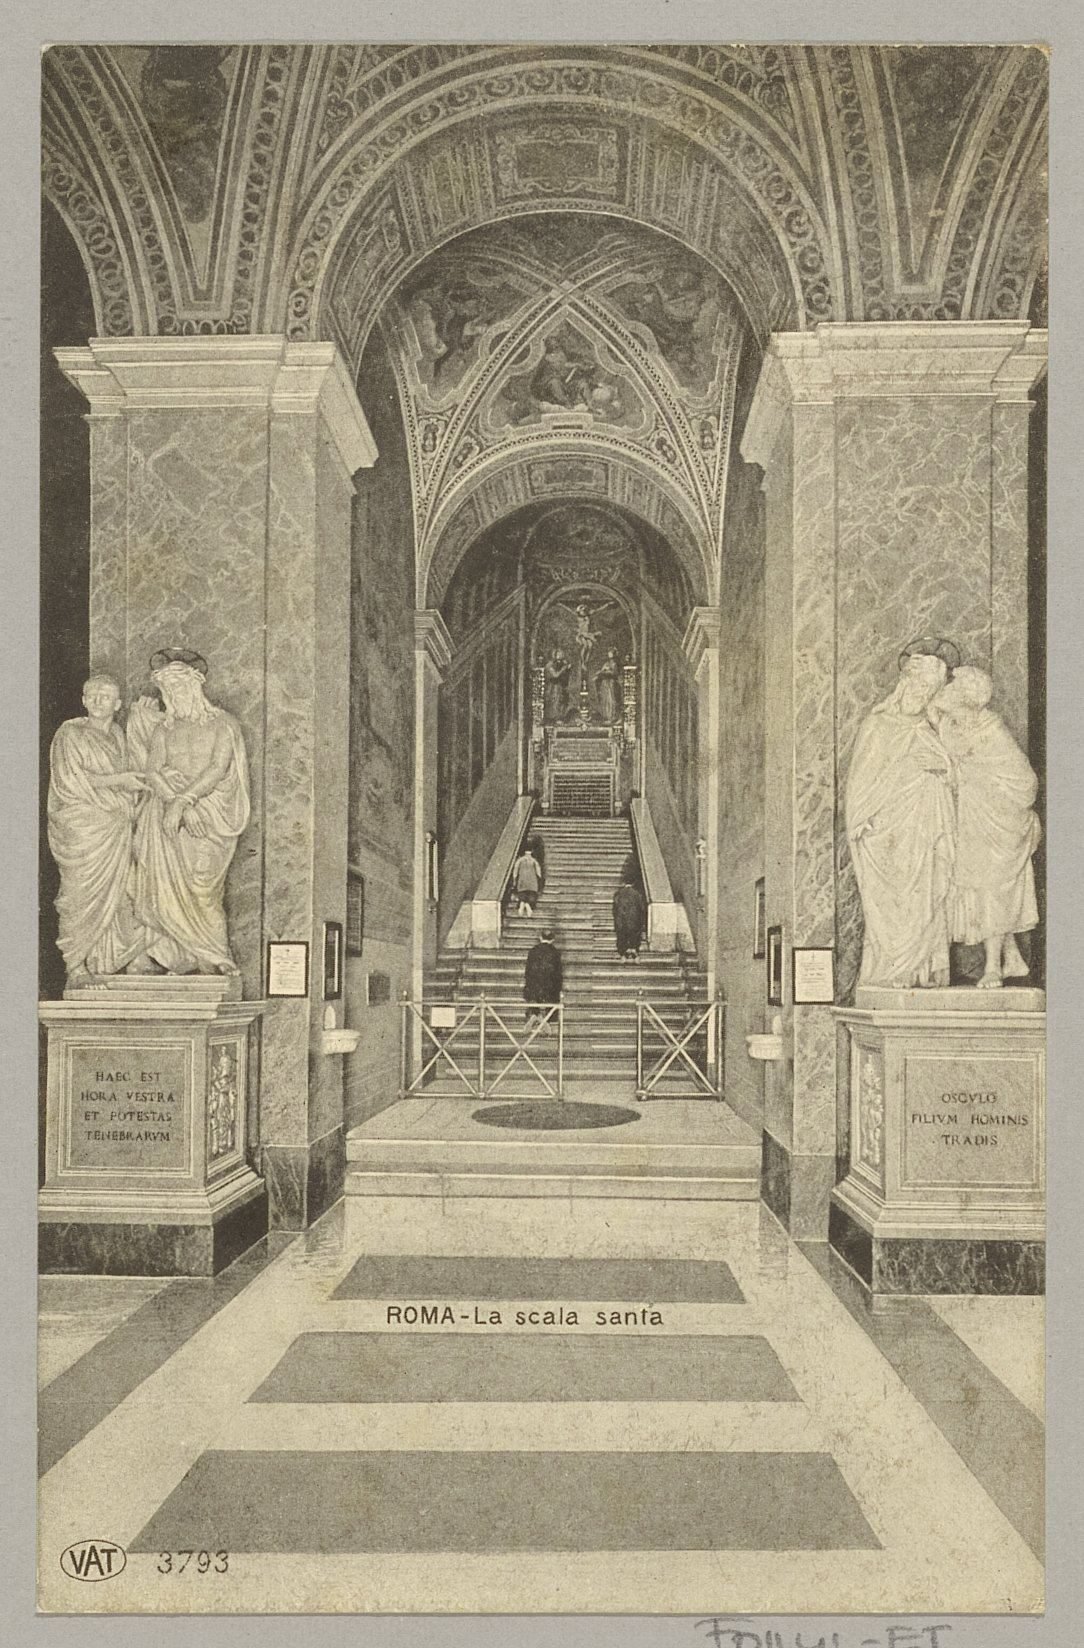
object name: ansichtkaart, prentbriefkaart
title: Roma - La scala santa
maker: Anonymous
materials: paper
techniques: autotype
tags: staircase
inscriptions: inscription: ‘VAT 3793’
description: Onderdeel van Fotoalbum van een reis door Zuid-Europa en het Midden-Oosten.